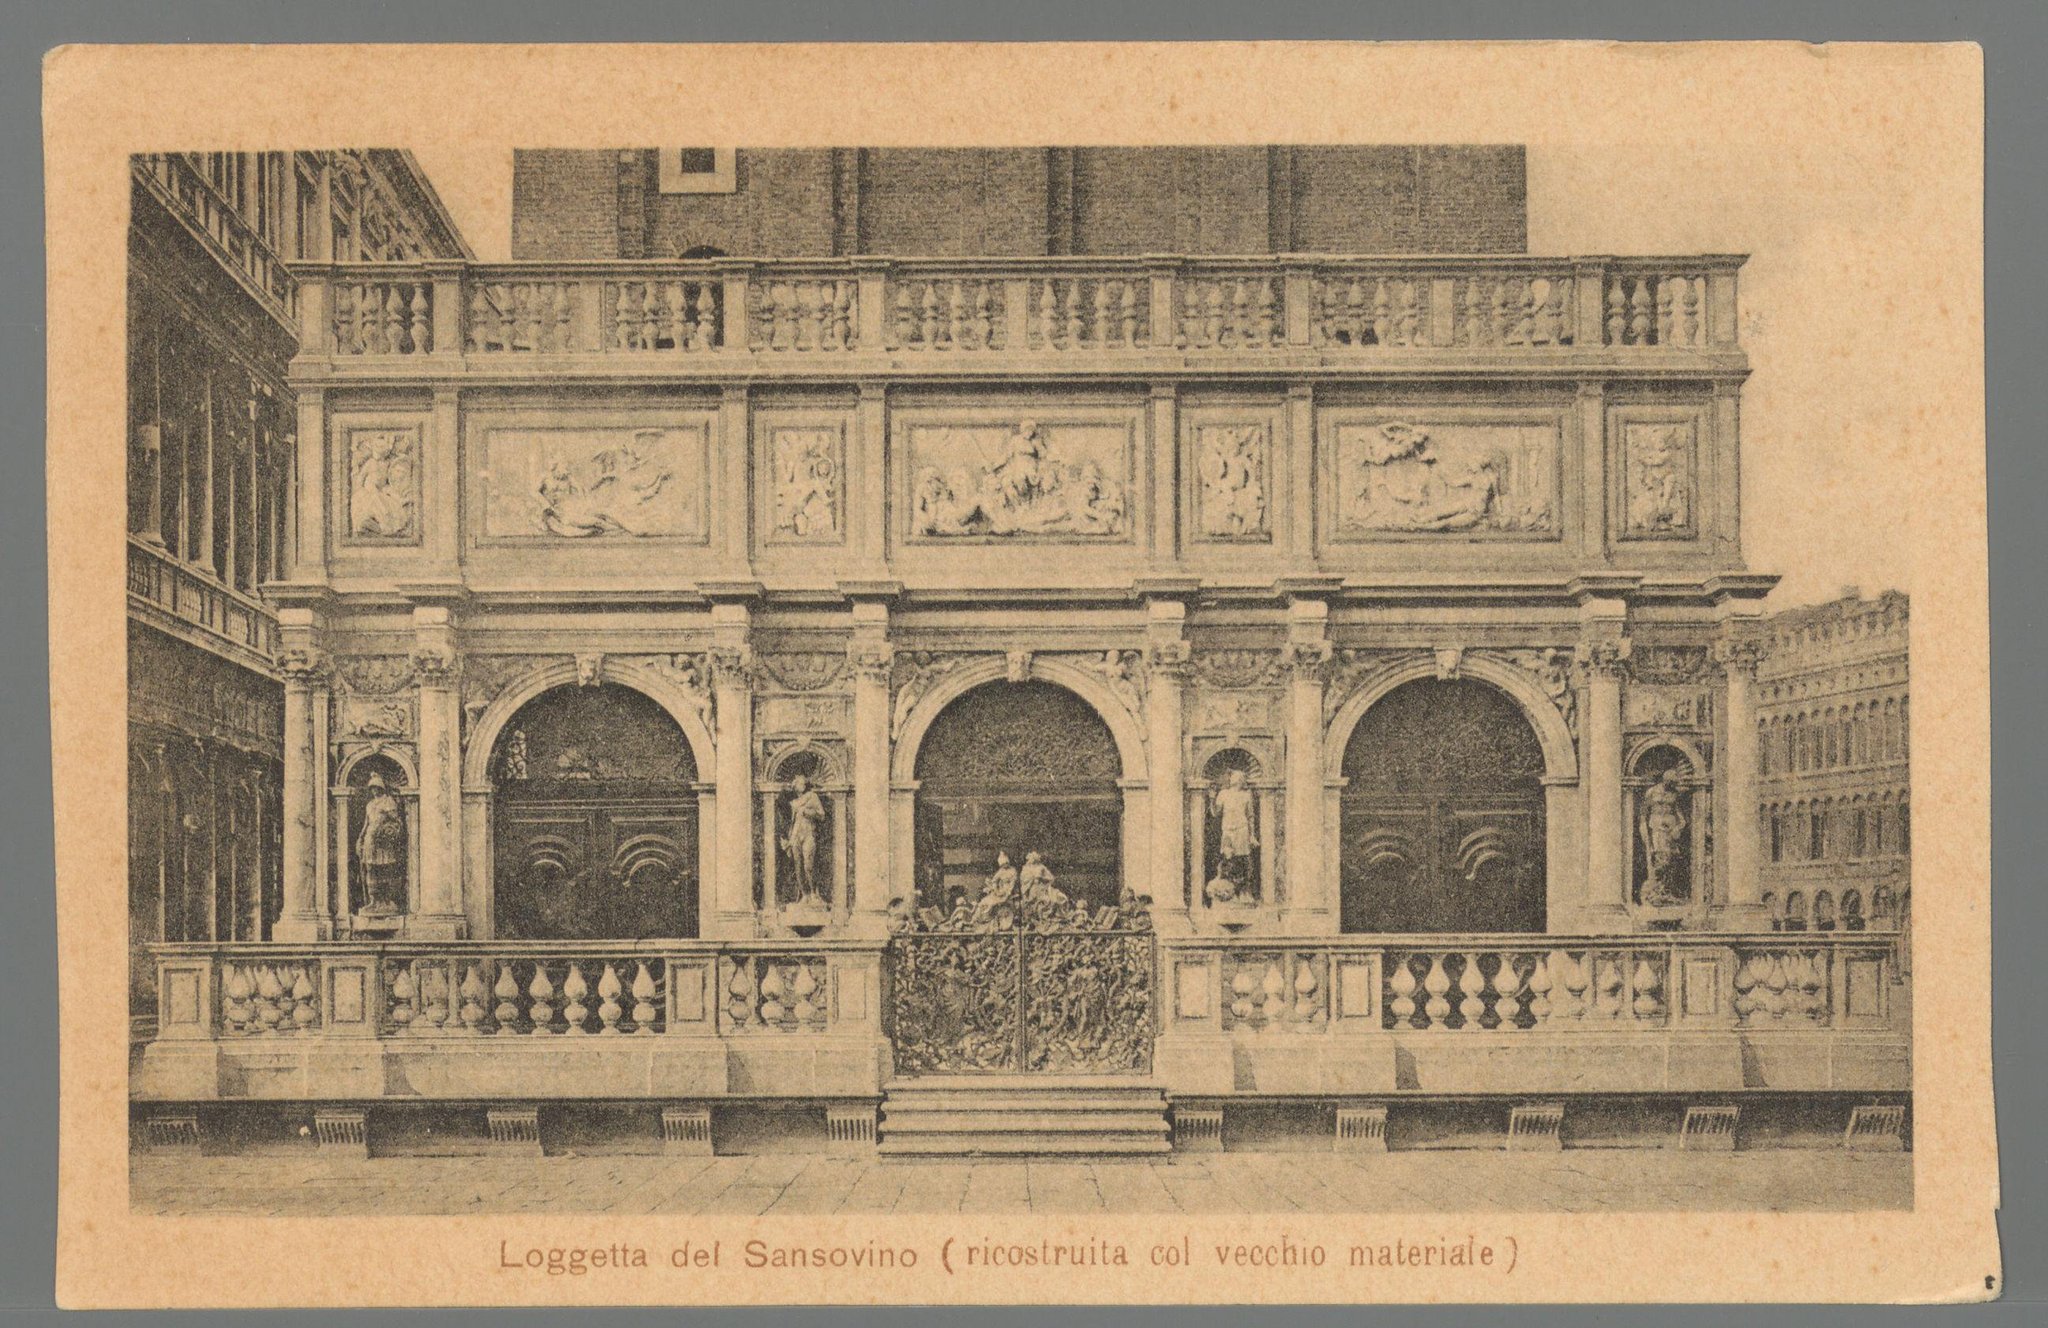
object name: photomechanical print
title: Loggetta del Sansovino (ricostruita col vecchio materiale)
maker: Anonymous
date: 1910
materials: cardboard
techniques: photograph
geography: venice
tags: city-view, and landscape with man-made constructions, triumphal arch